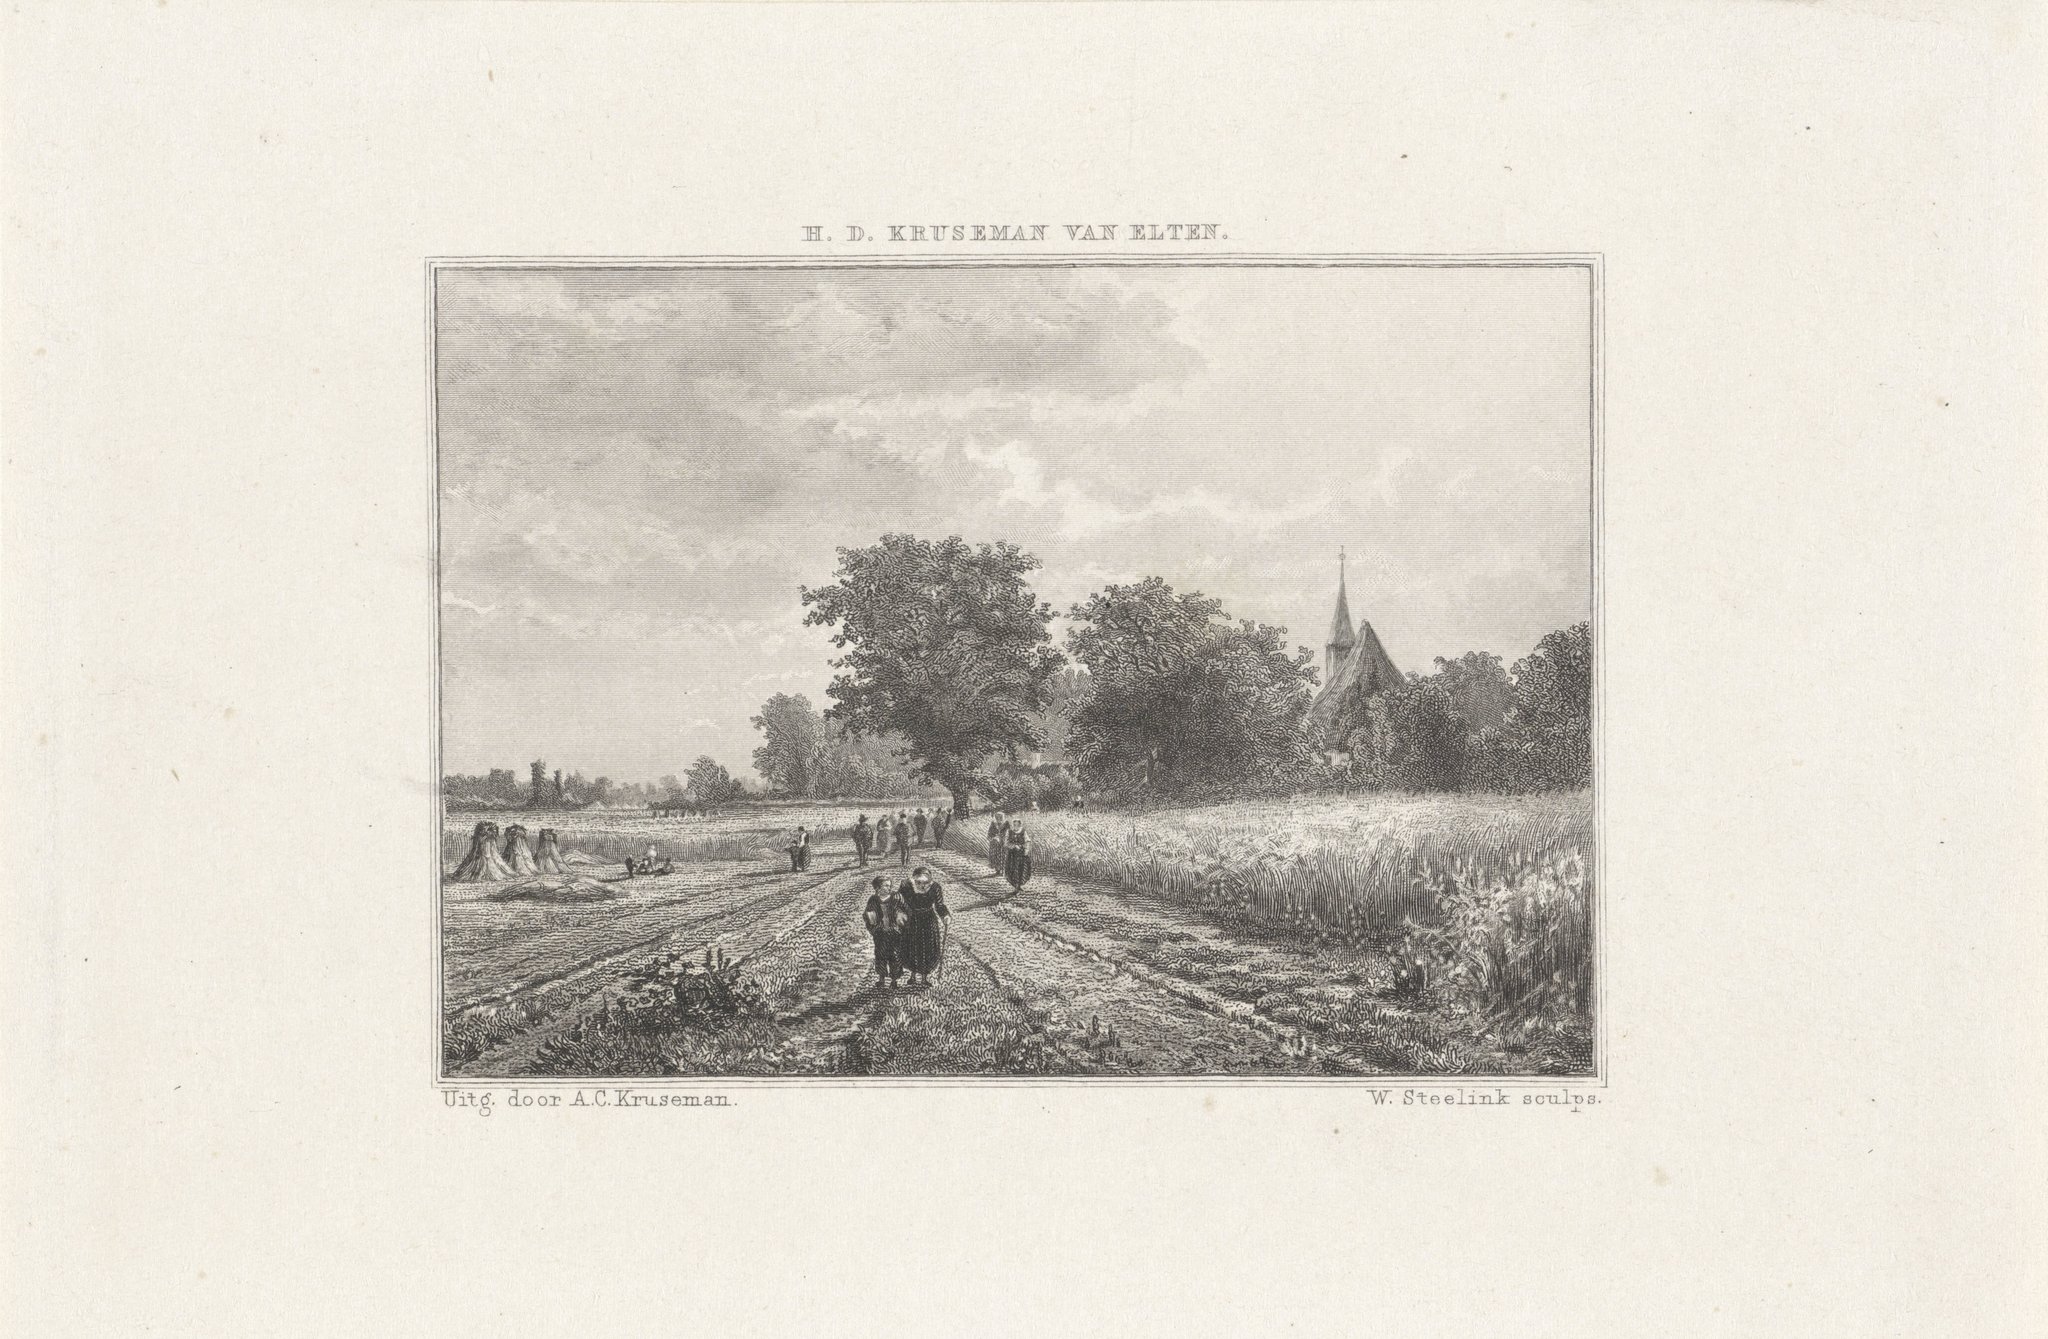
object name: print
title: Mensen op een weg in de graanvelden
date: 1859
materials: paper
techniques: etching, engraving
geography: haarlem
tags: field filled with a crop, public road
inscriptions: collector's mark: Lugt 2228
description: Verschillende mensen lopen over een weg door graanvelden. Een jongen ondersteunt een oude vrouw. Rechts tussen de bomen een kerk.